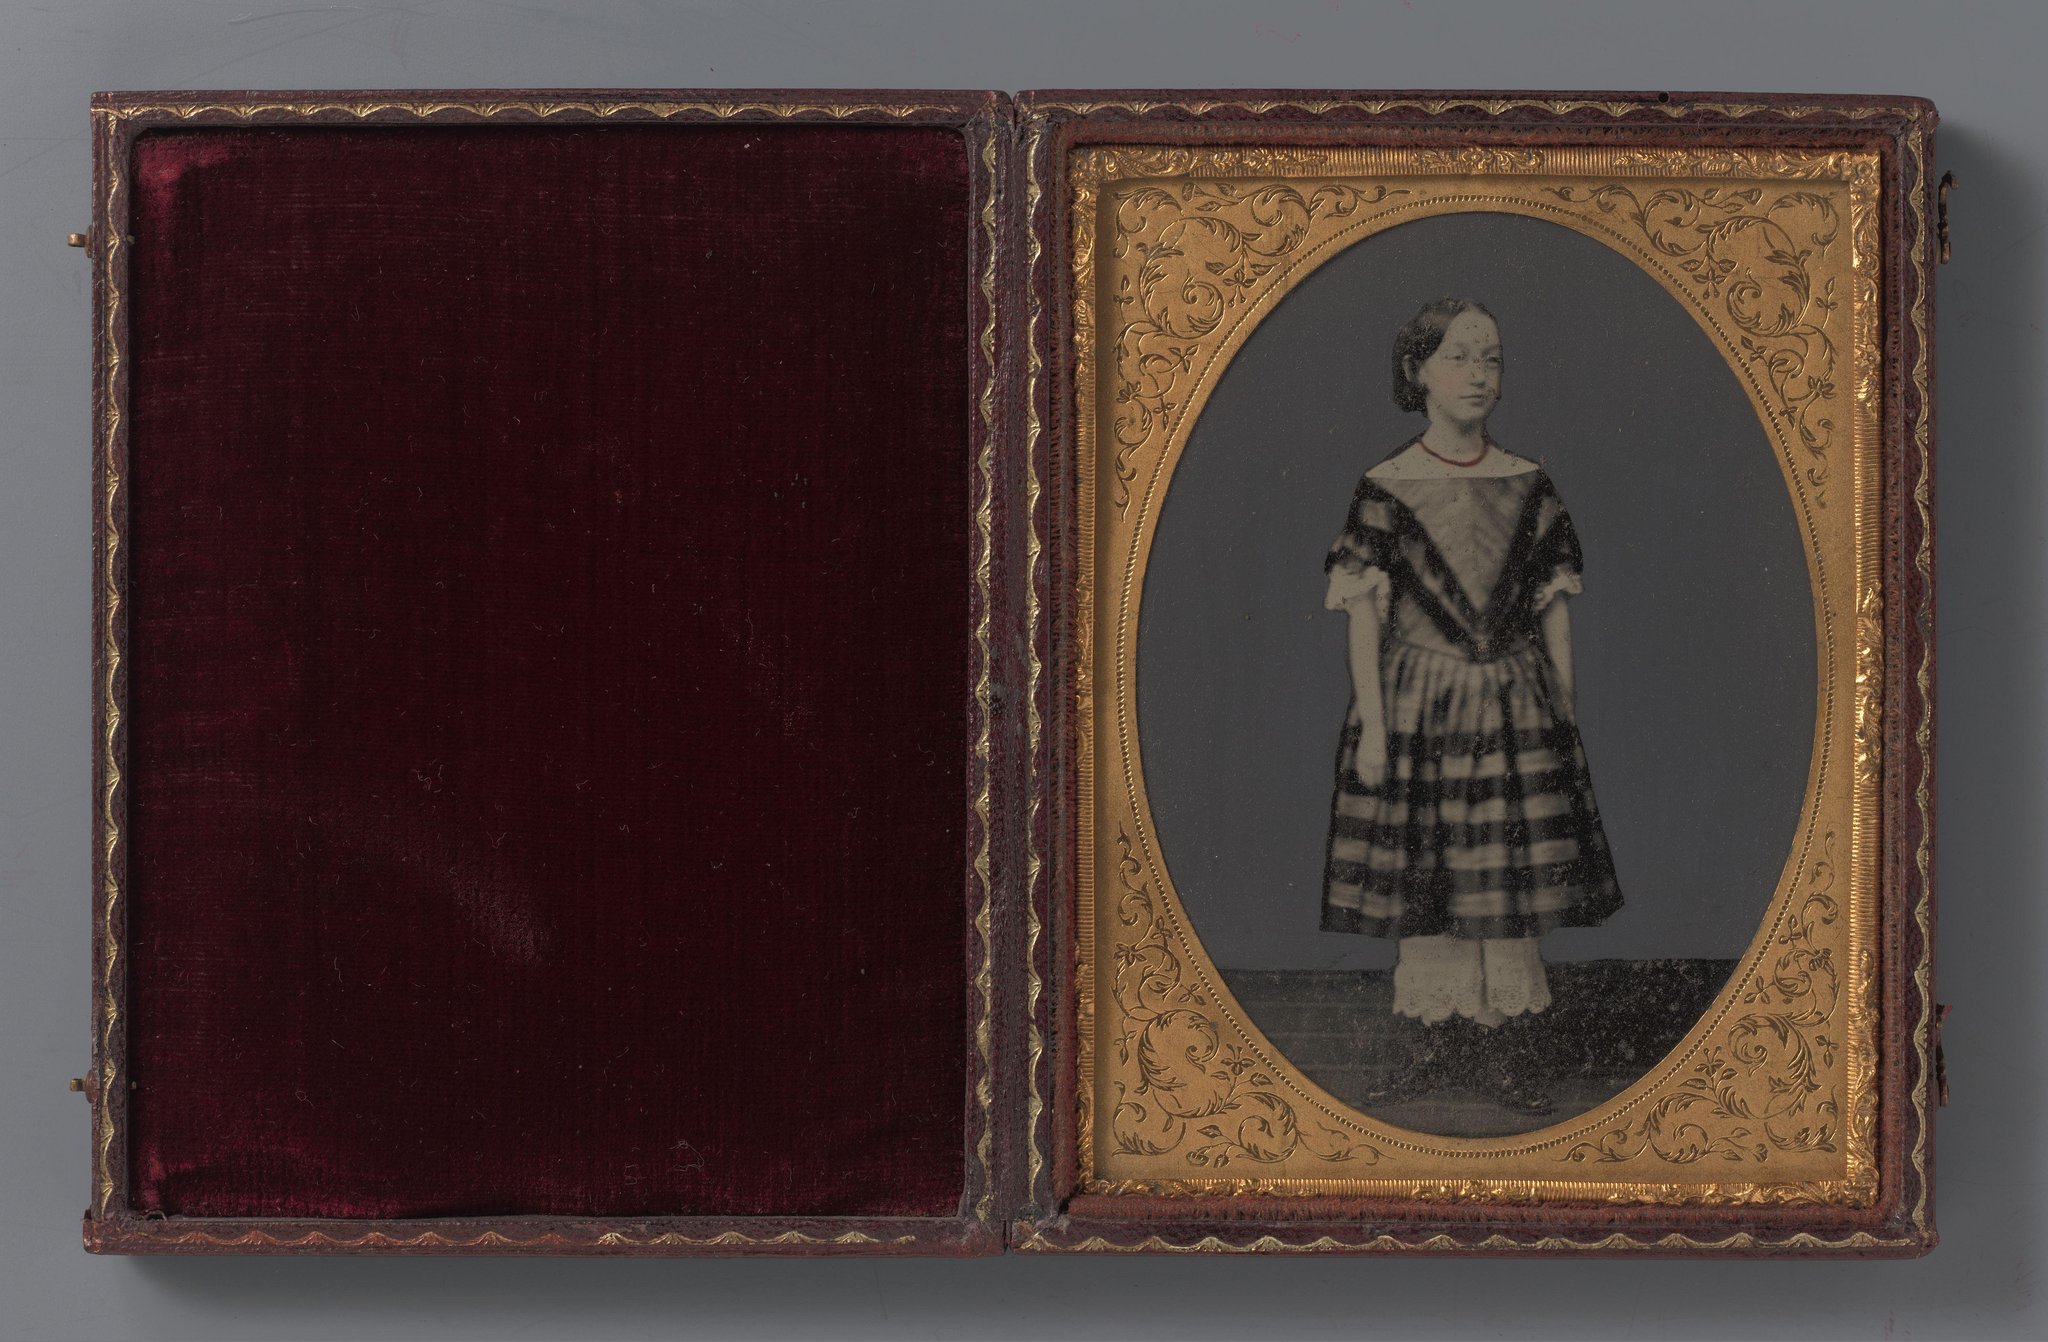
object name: photograph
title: Portret van een onbekend meisje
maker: Anonymous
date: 1855-1870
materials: glass, leather, metal, velvet, wood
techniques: ambrotype, hand coloring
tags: historical persons - bb - woman, girl (child between toddler and youth), standing figure - aa - female human figure